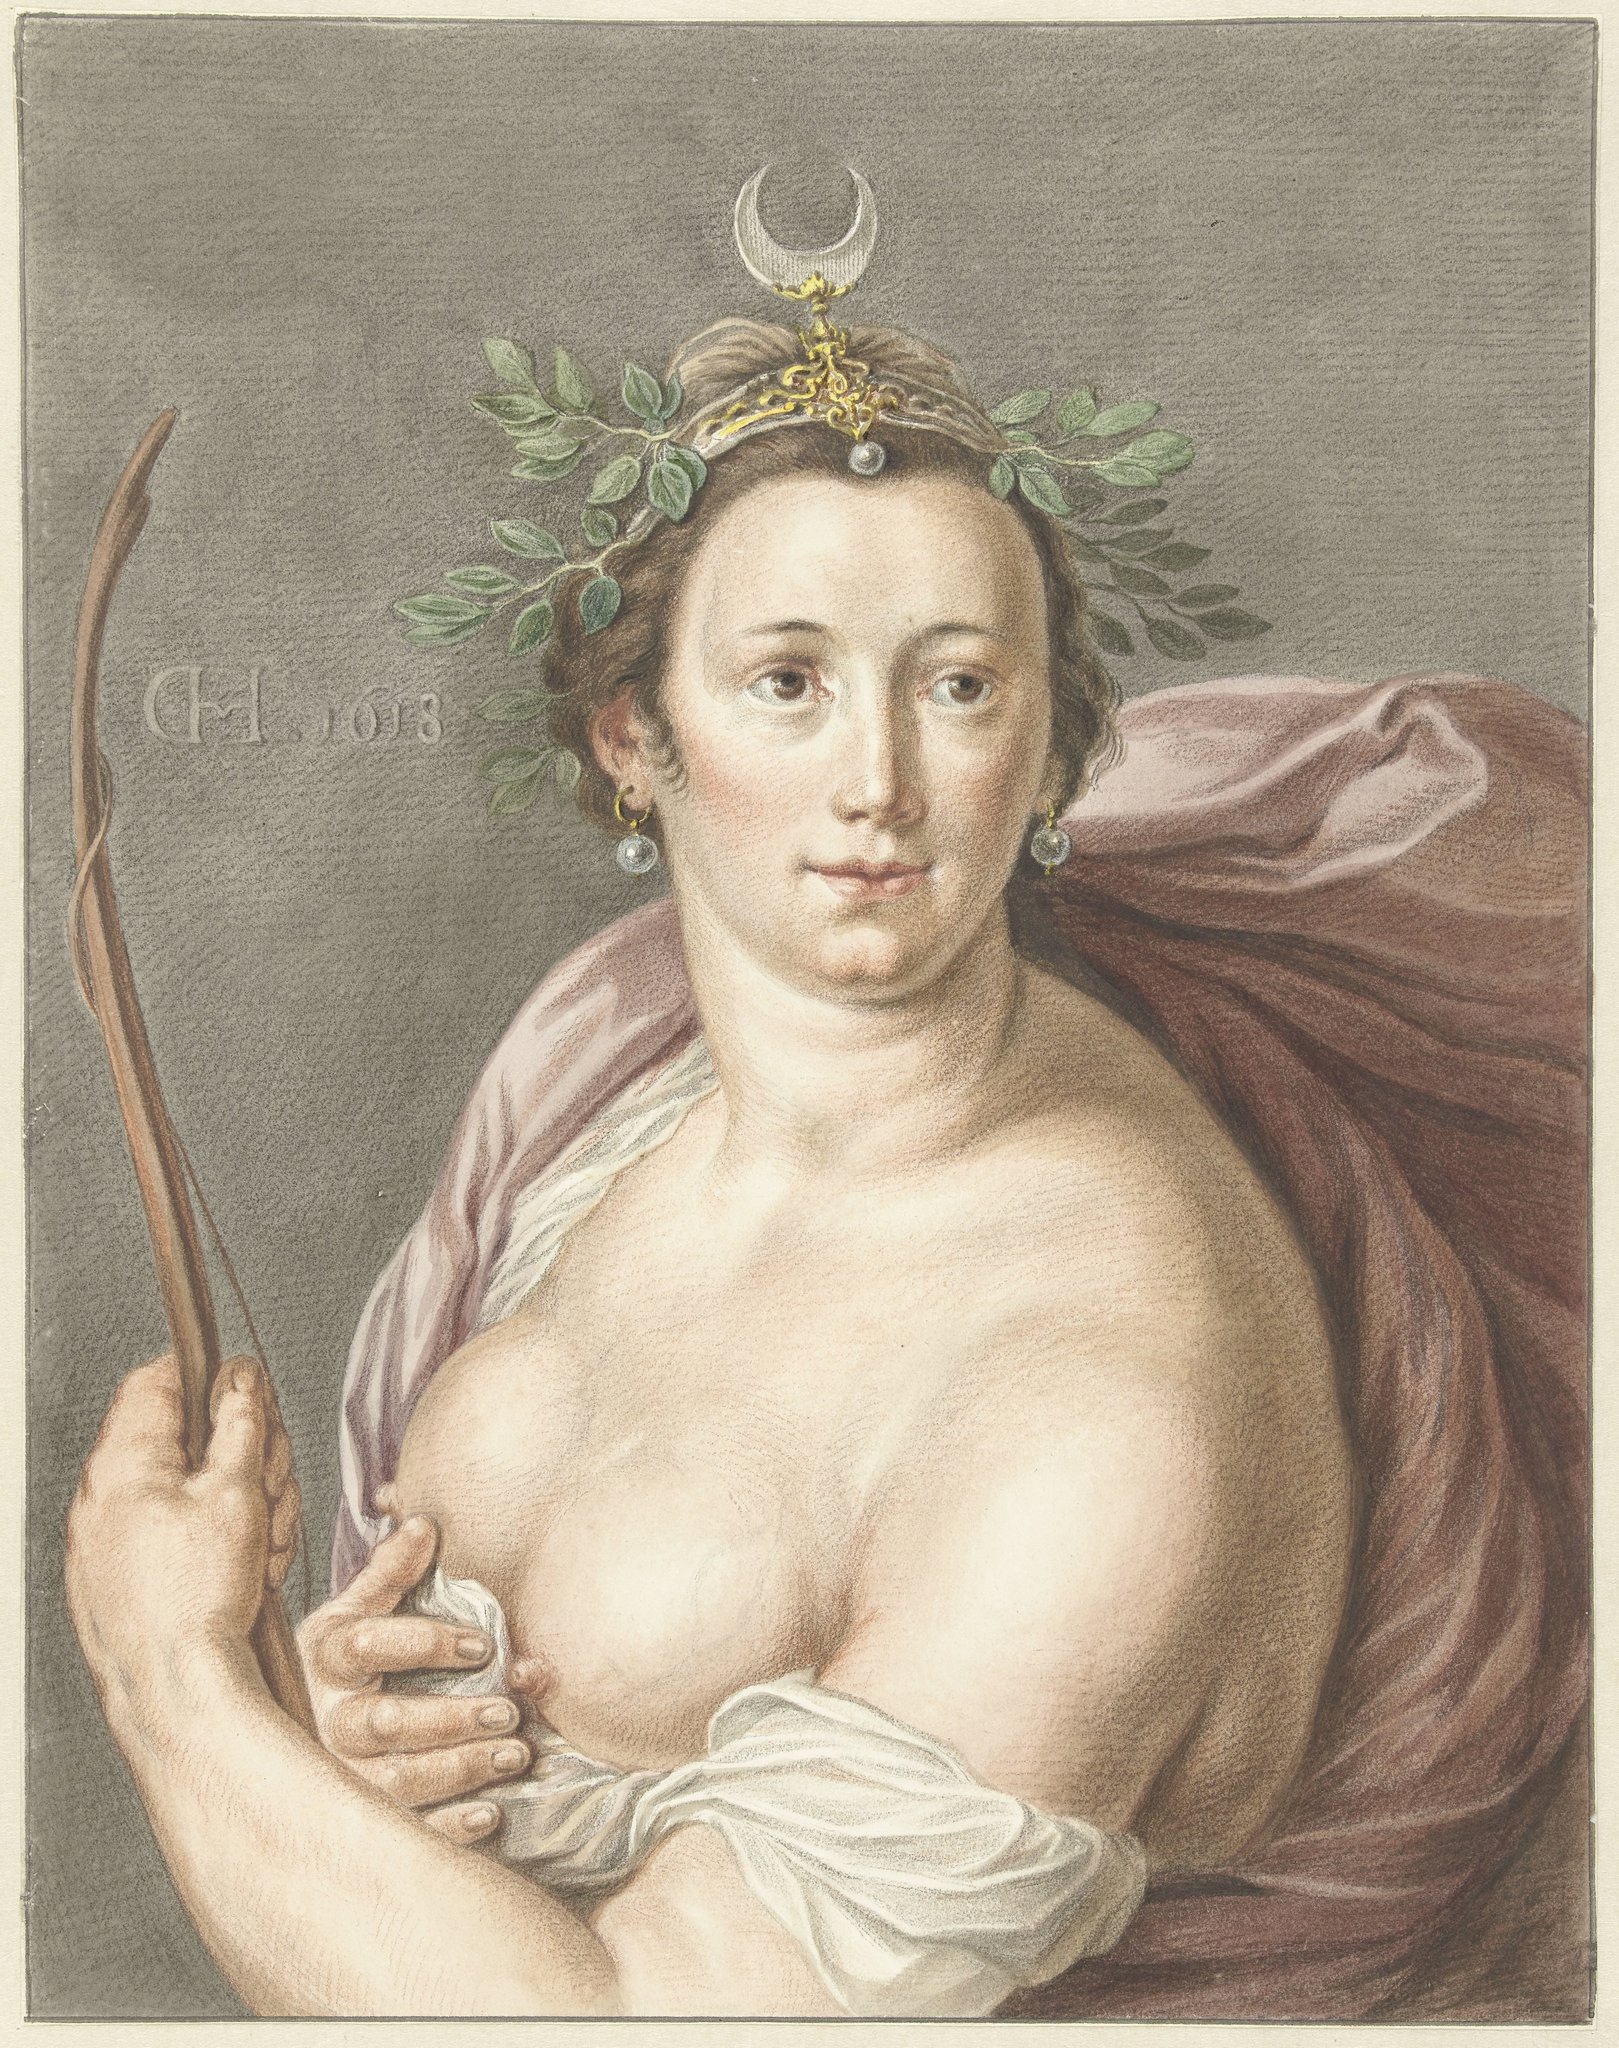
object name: watercolor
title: Diana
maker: abraham delfos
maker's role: draughtsman, painter, print maker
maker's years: 1731-1820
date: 1795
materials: chalk, paper, watercolor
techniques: brush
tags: (story of) diana (artemis)